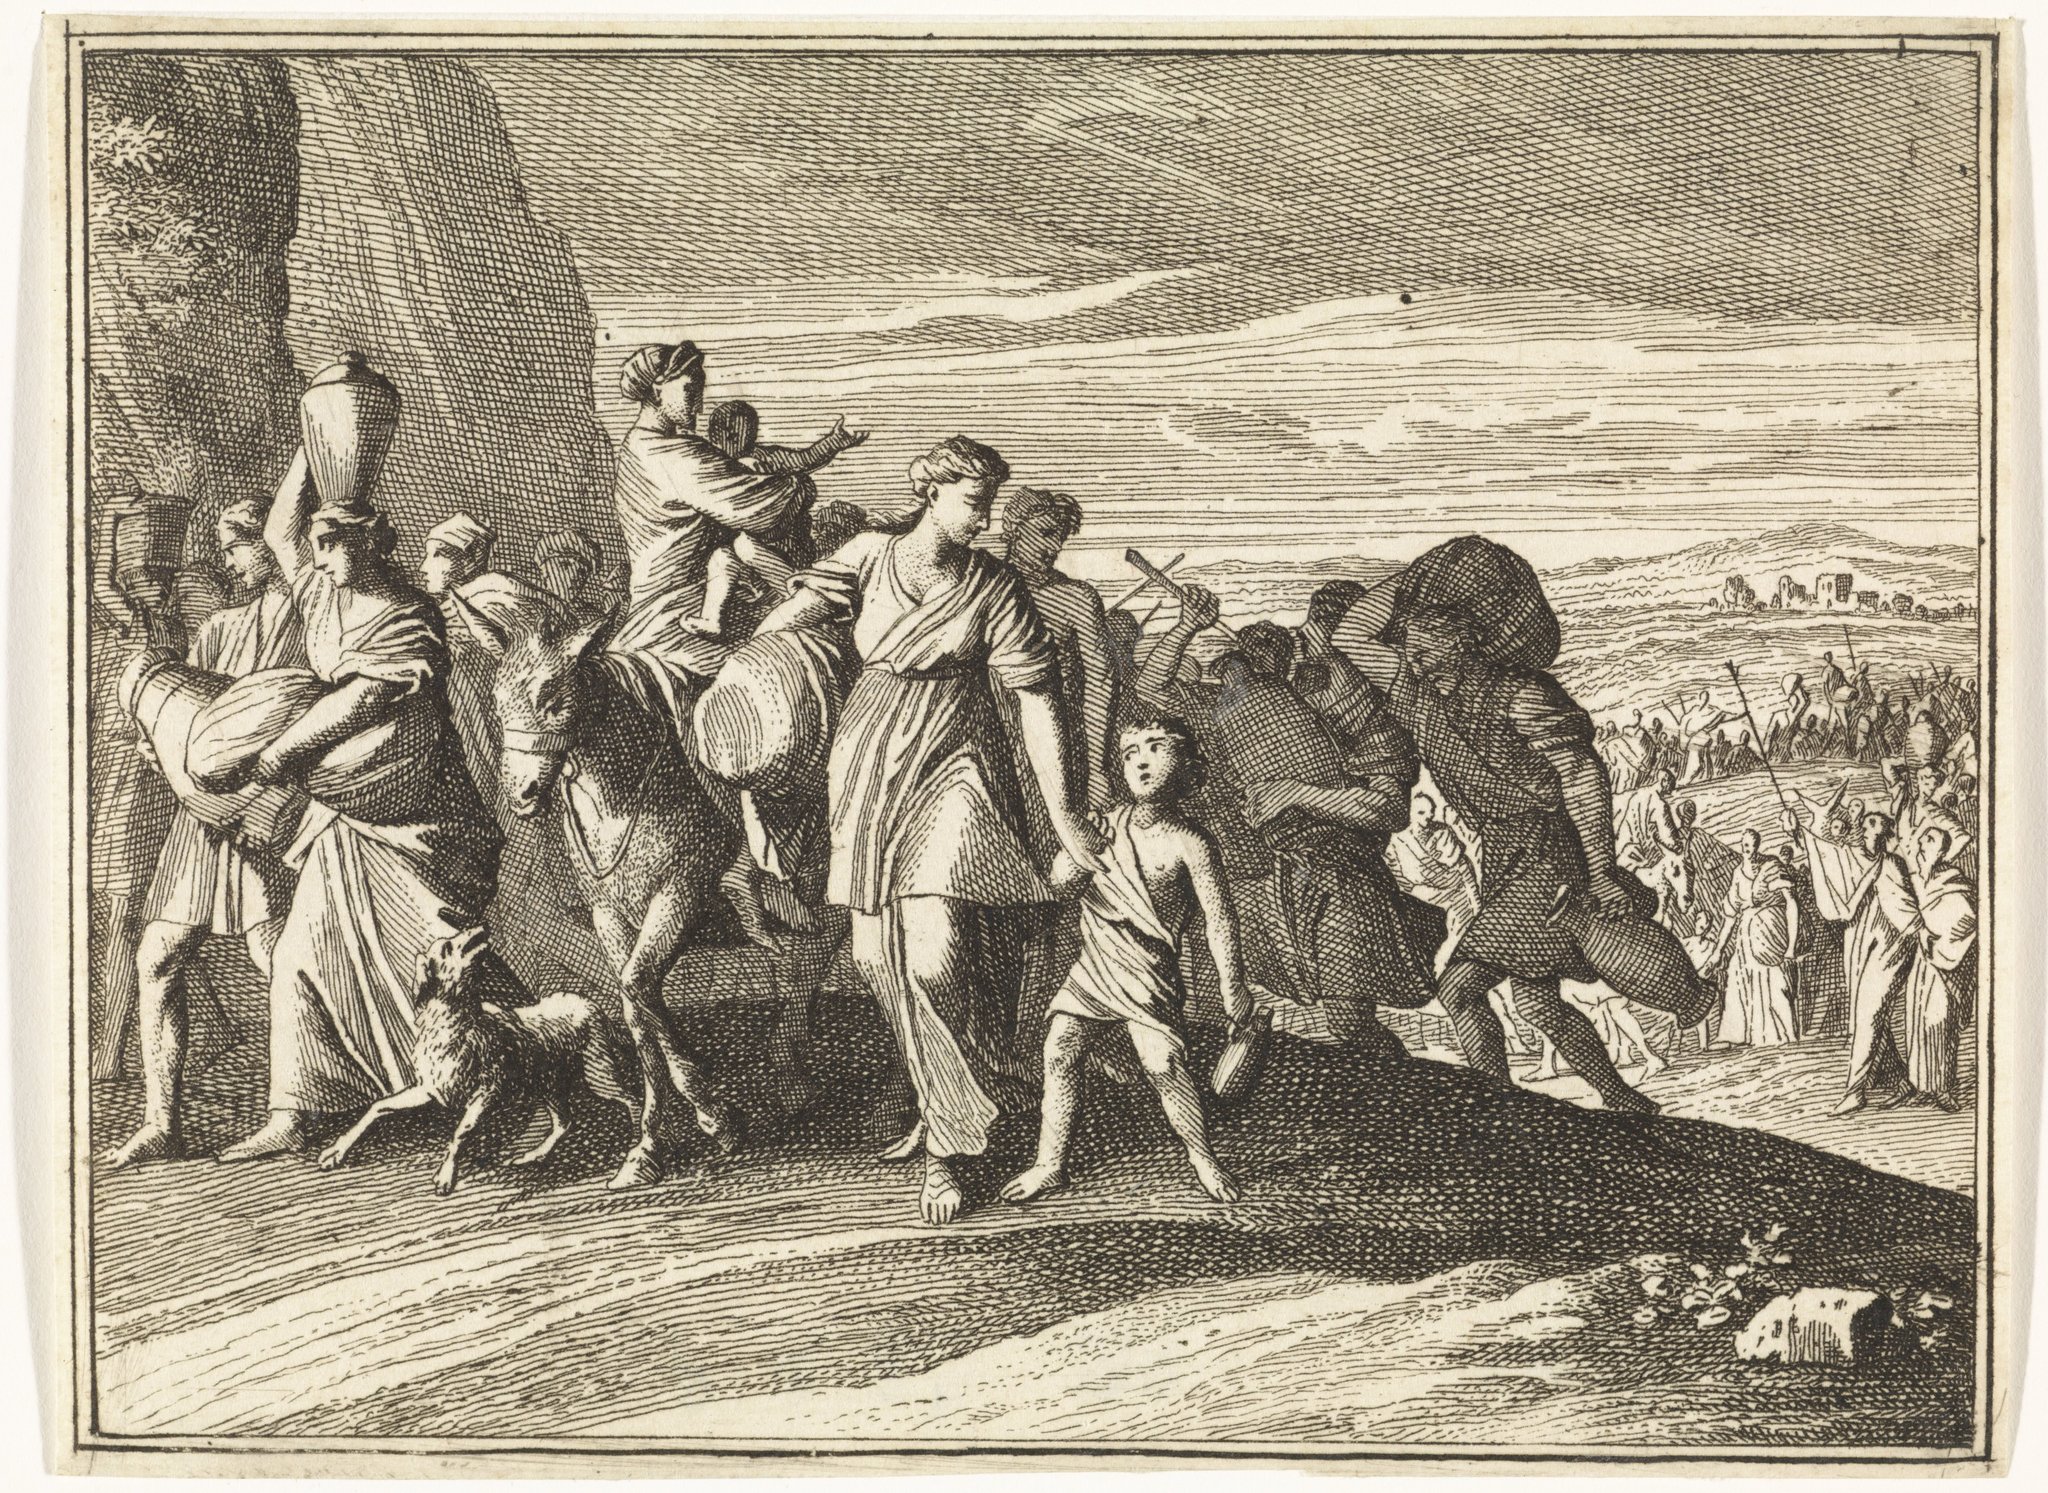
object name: print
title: Uittocht uit Egypte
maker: caspar luyken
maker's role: draughtsman, print maker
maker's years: 1672-1708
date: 1712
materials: paper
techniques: etching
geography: amsterdam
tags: the israelites leave egypt; first movement from rameses to succoth (exodus 12:31 - 13:16)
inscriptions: number: ‘61’, collector's mark: Lugt 2228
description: Illustratie uit: Luyken, Jan. De schriftuurlyke geschiedenissen en gelykenissen van het Oude en Nieuwe Verbond, 2 delen. Amsterdam: Wed. Pieter Arentsz II en Cornelis van der Sys, 1712, dl. I.